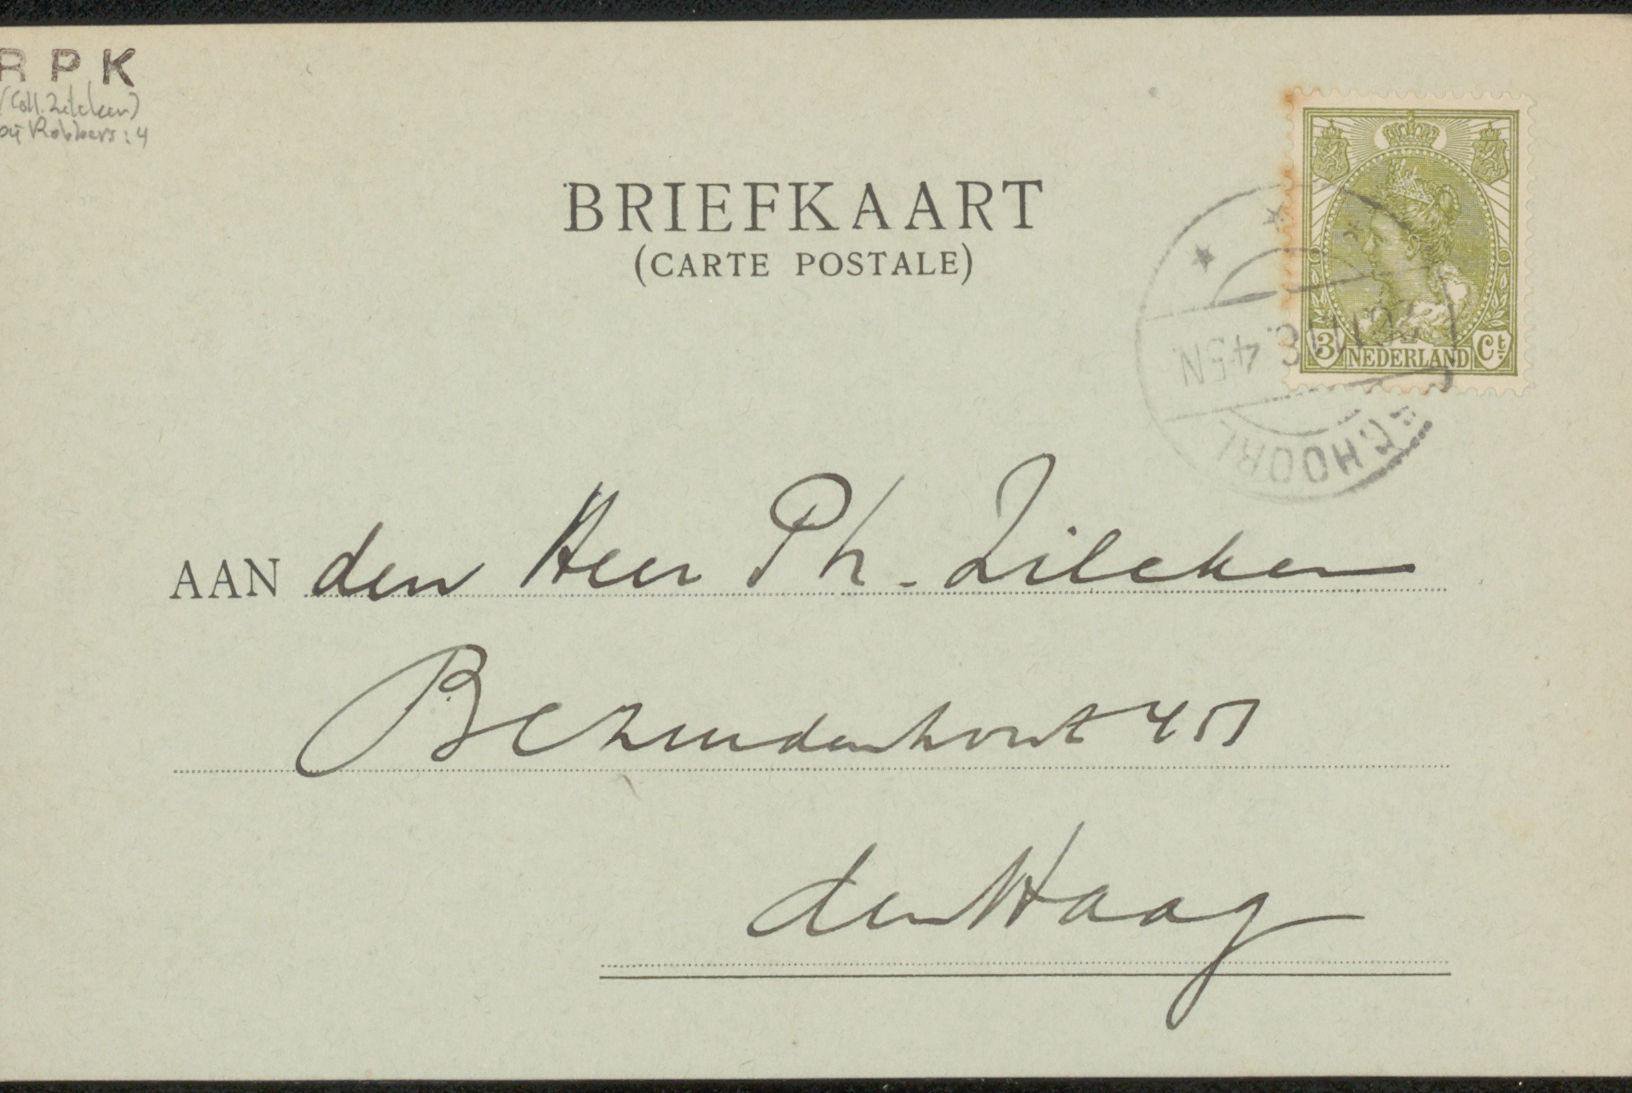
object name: postcard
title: Briefkaart aan Philip Zilcken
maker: herman robbers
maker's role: redacteur, schrijver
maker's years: 1868-1937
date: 1918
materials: cardboard, ink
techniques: pen, printing, writing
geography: schoorl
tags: print maker, draughtsman, reinier willem petrus de vries (1874-1953), the hague, philip zilcken, illustration ~ printed matter, book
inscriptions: collector's mark: ‘RPK’